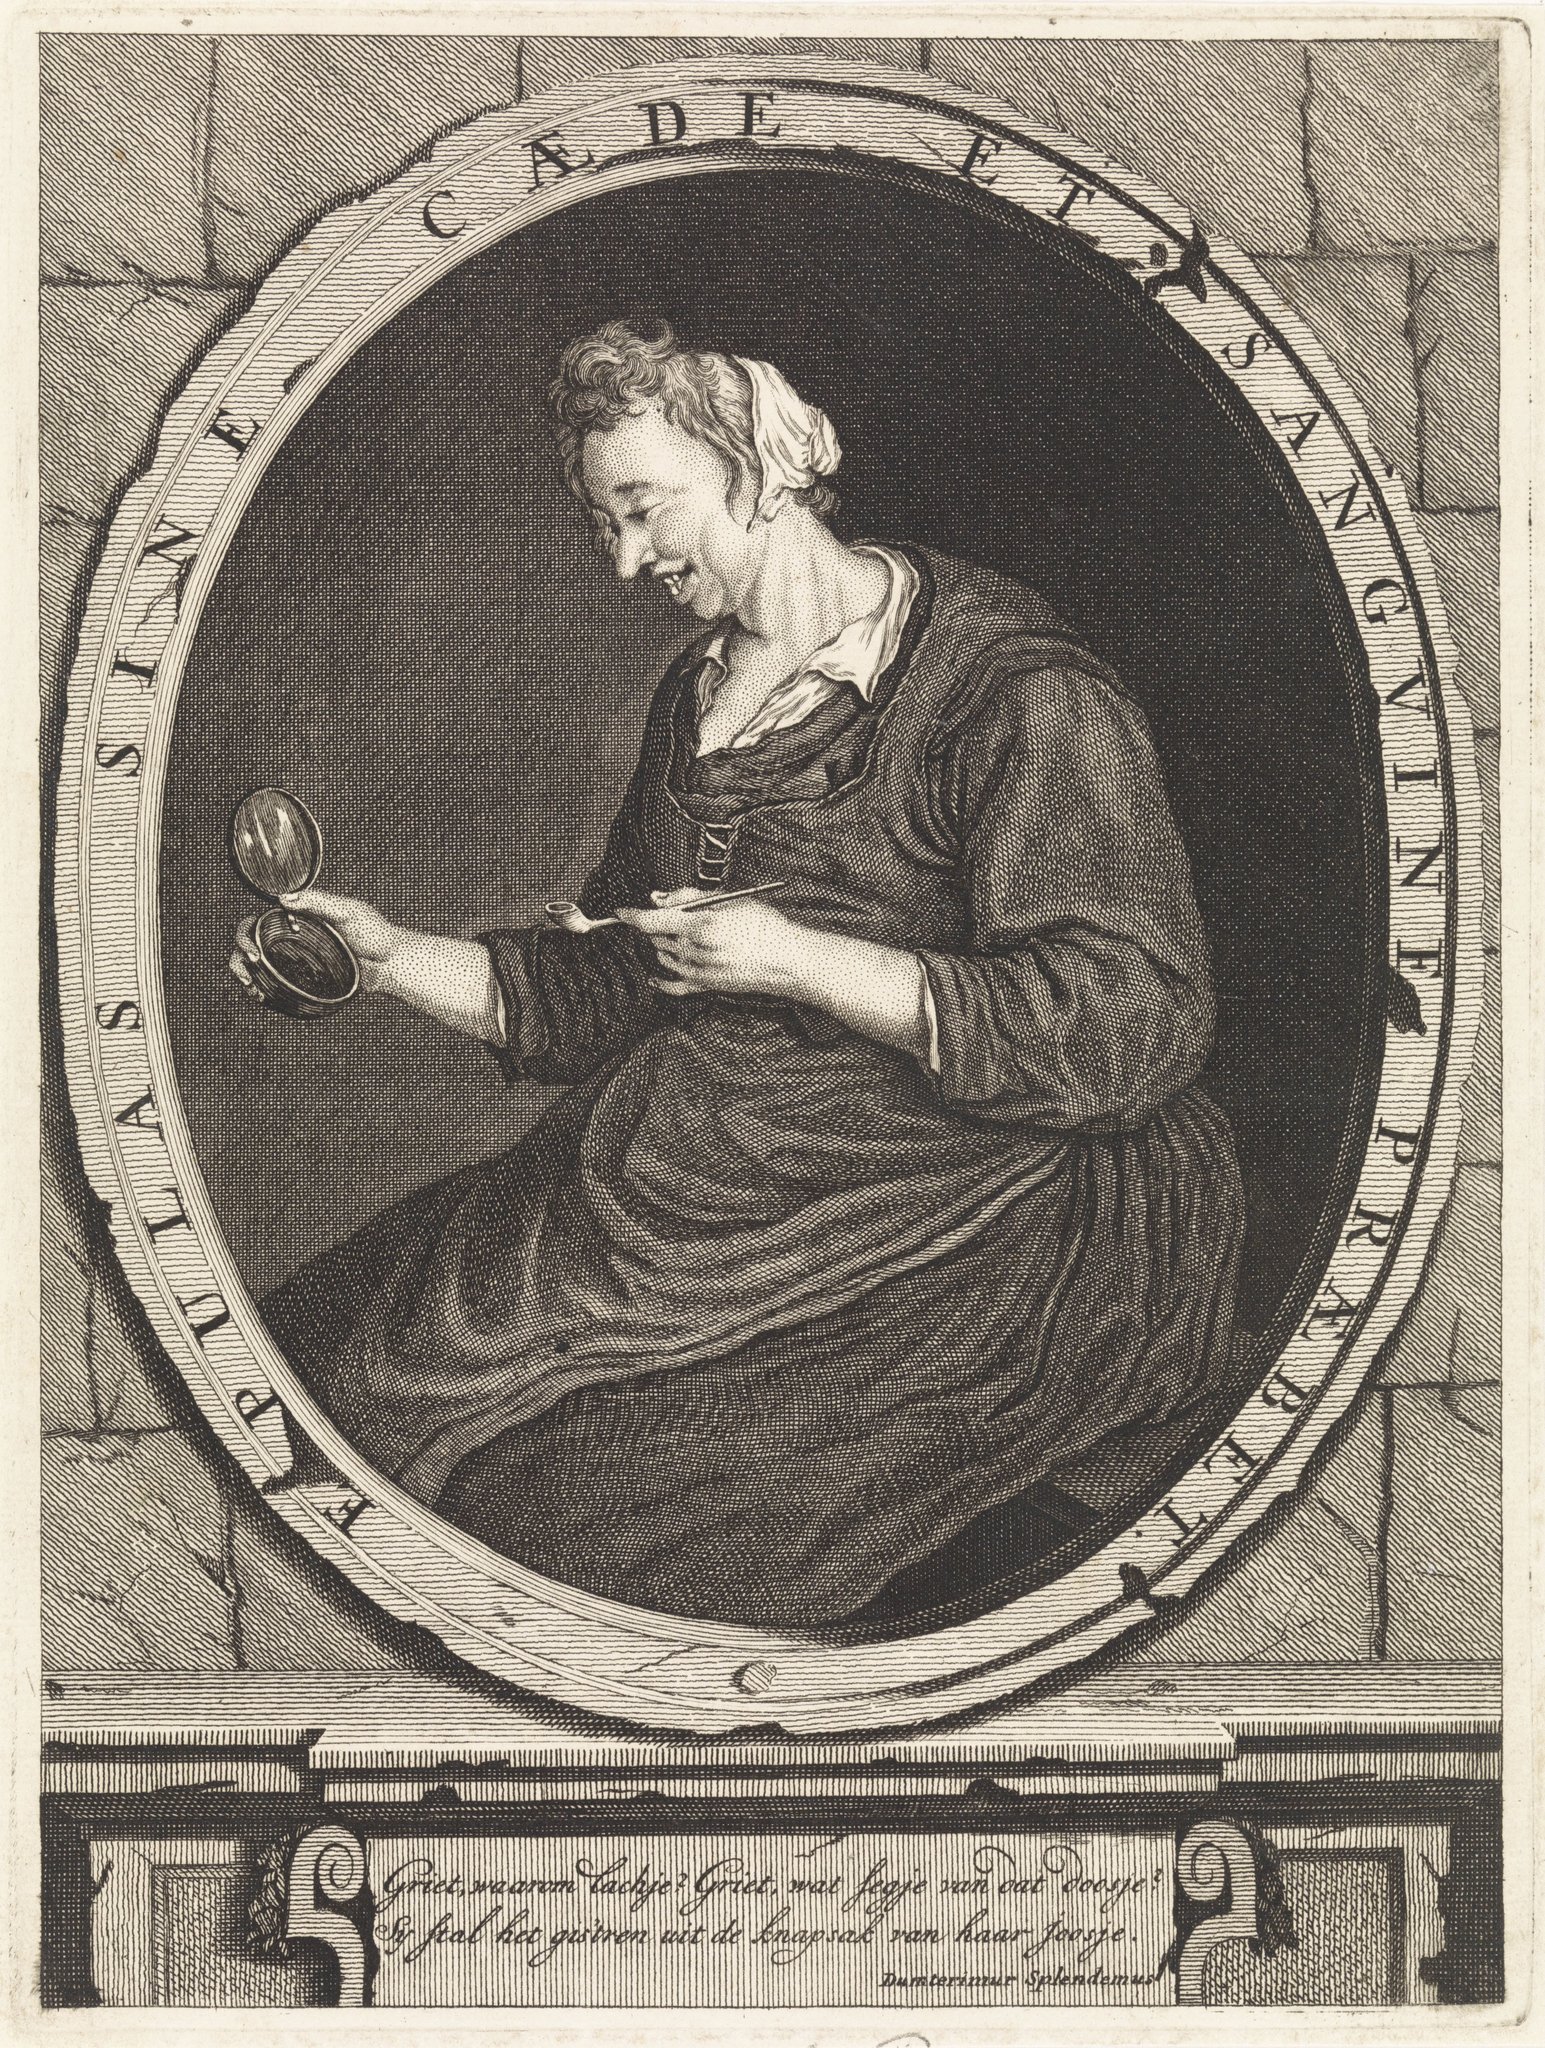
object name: print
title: Rokende boerin met pijp en test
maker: matthijs pool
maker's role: print maker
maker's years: 1676-1740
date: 1696-1727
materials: paper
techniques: engraving, etching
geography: amsterdam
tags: pipe ~ tobacco, farmers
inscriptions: collector's mark: Lugt 2228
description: Een boerin zit op een kruk en lacht. In haar handen heeft zij een pijp en een testje met een kooltje vuur. In het kader onder de voorstelling een spotgedicht.